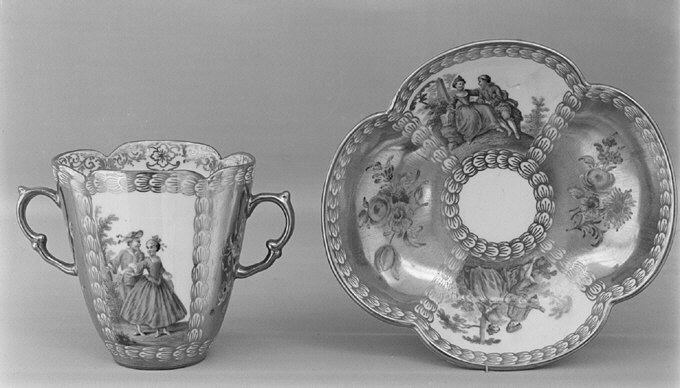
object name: cup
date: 1801-1900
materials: hard paste porcelain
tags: men,women,flowers